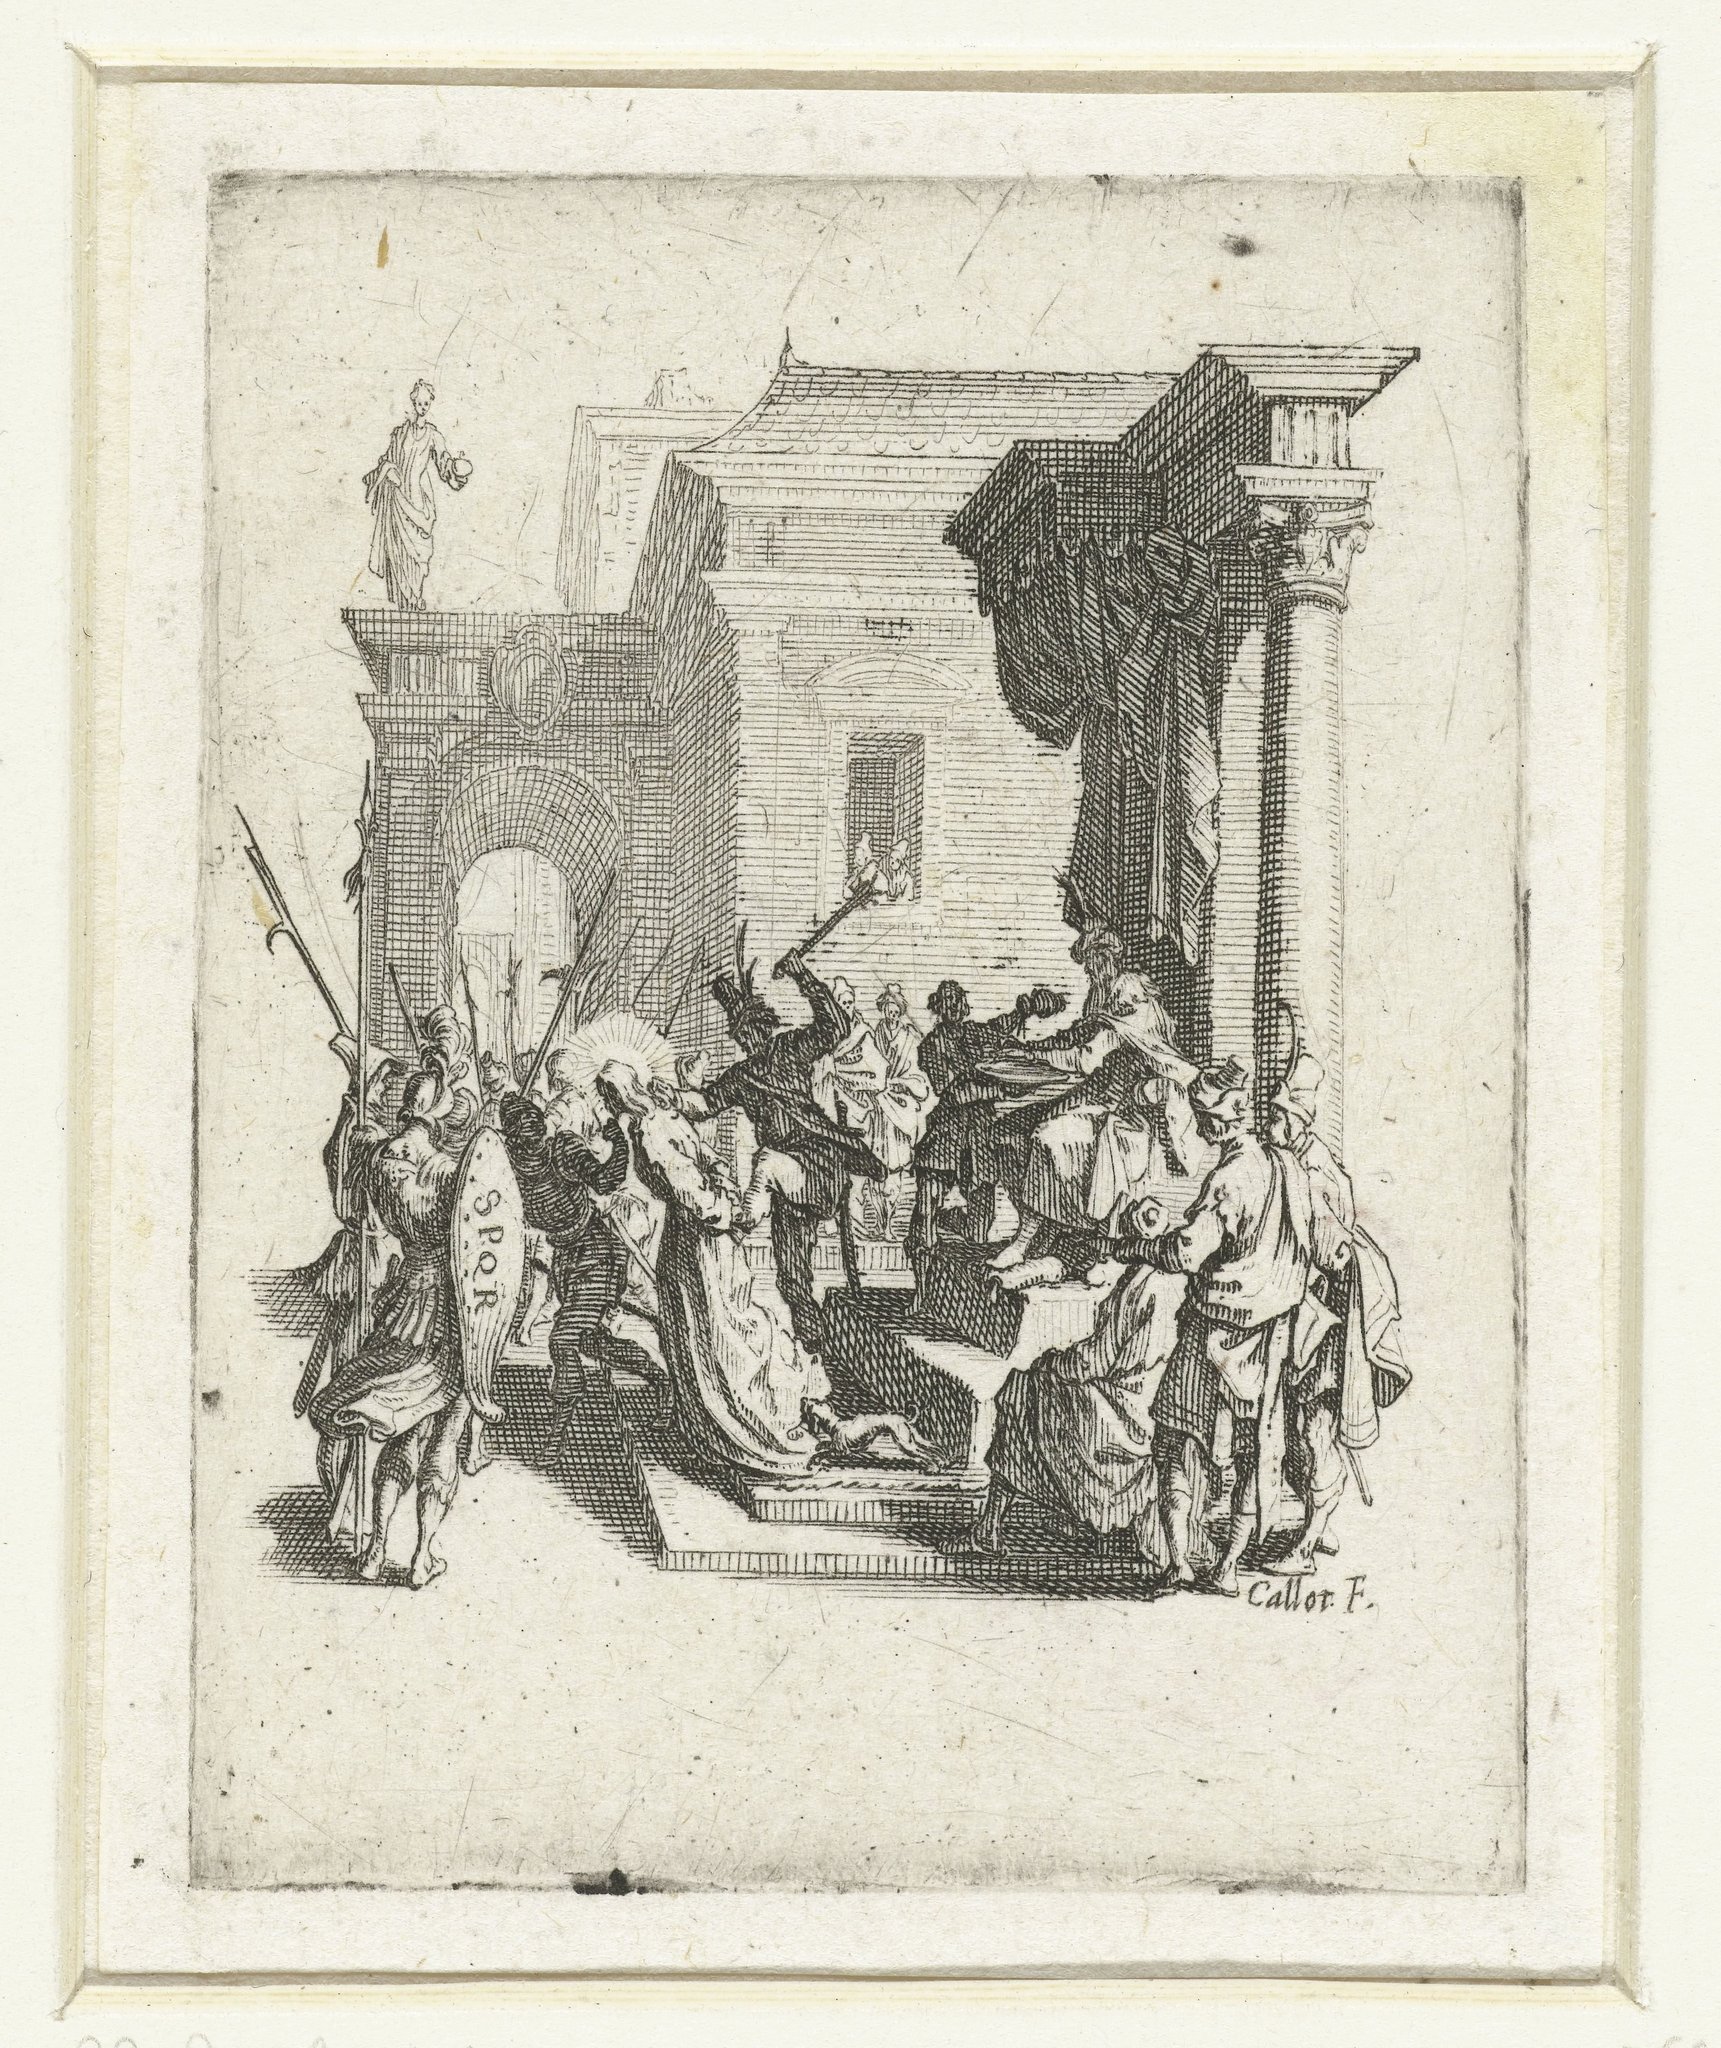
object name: print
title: Pilatus wast zijn handen in onschuld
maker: jacques callot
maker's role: draughtsman, print maker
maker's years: 1592-1635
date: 1624-1625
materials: paper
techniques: etching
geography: nancy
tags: pilate washing his hands (in innocence)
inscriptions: collector's mark: Lugt 240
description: Op een bordes wast Pilatus zijn handen boven een schotel die een bediende voor hem vasthoudt. Christus wordt ondertussen door soldaten weggeleid. Deze prent is onderdeel van de prentserie 'De kleine Passie', bestaande uit 12 scènes uit het Lijdensverhaal.